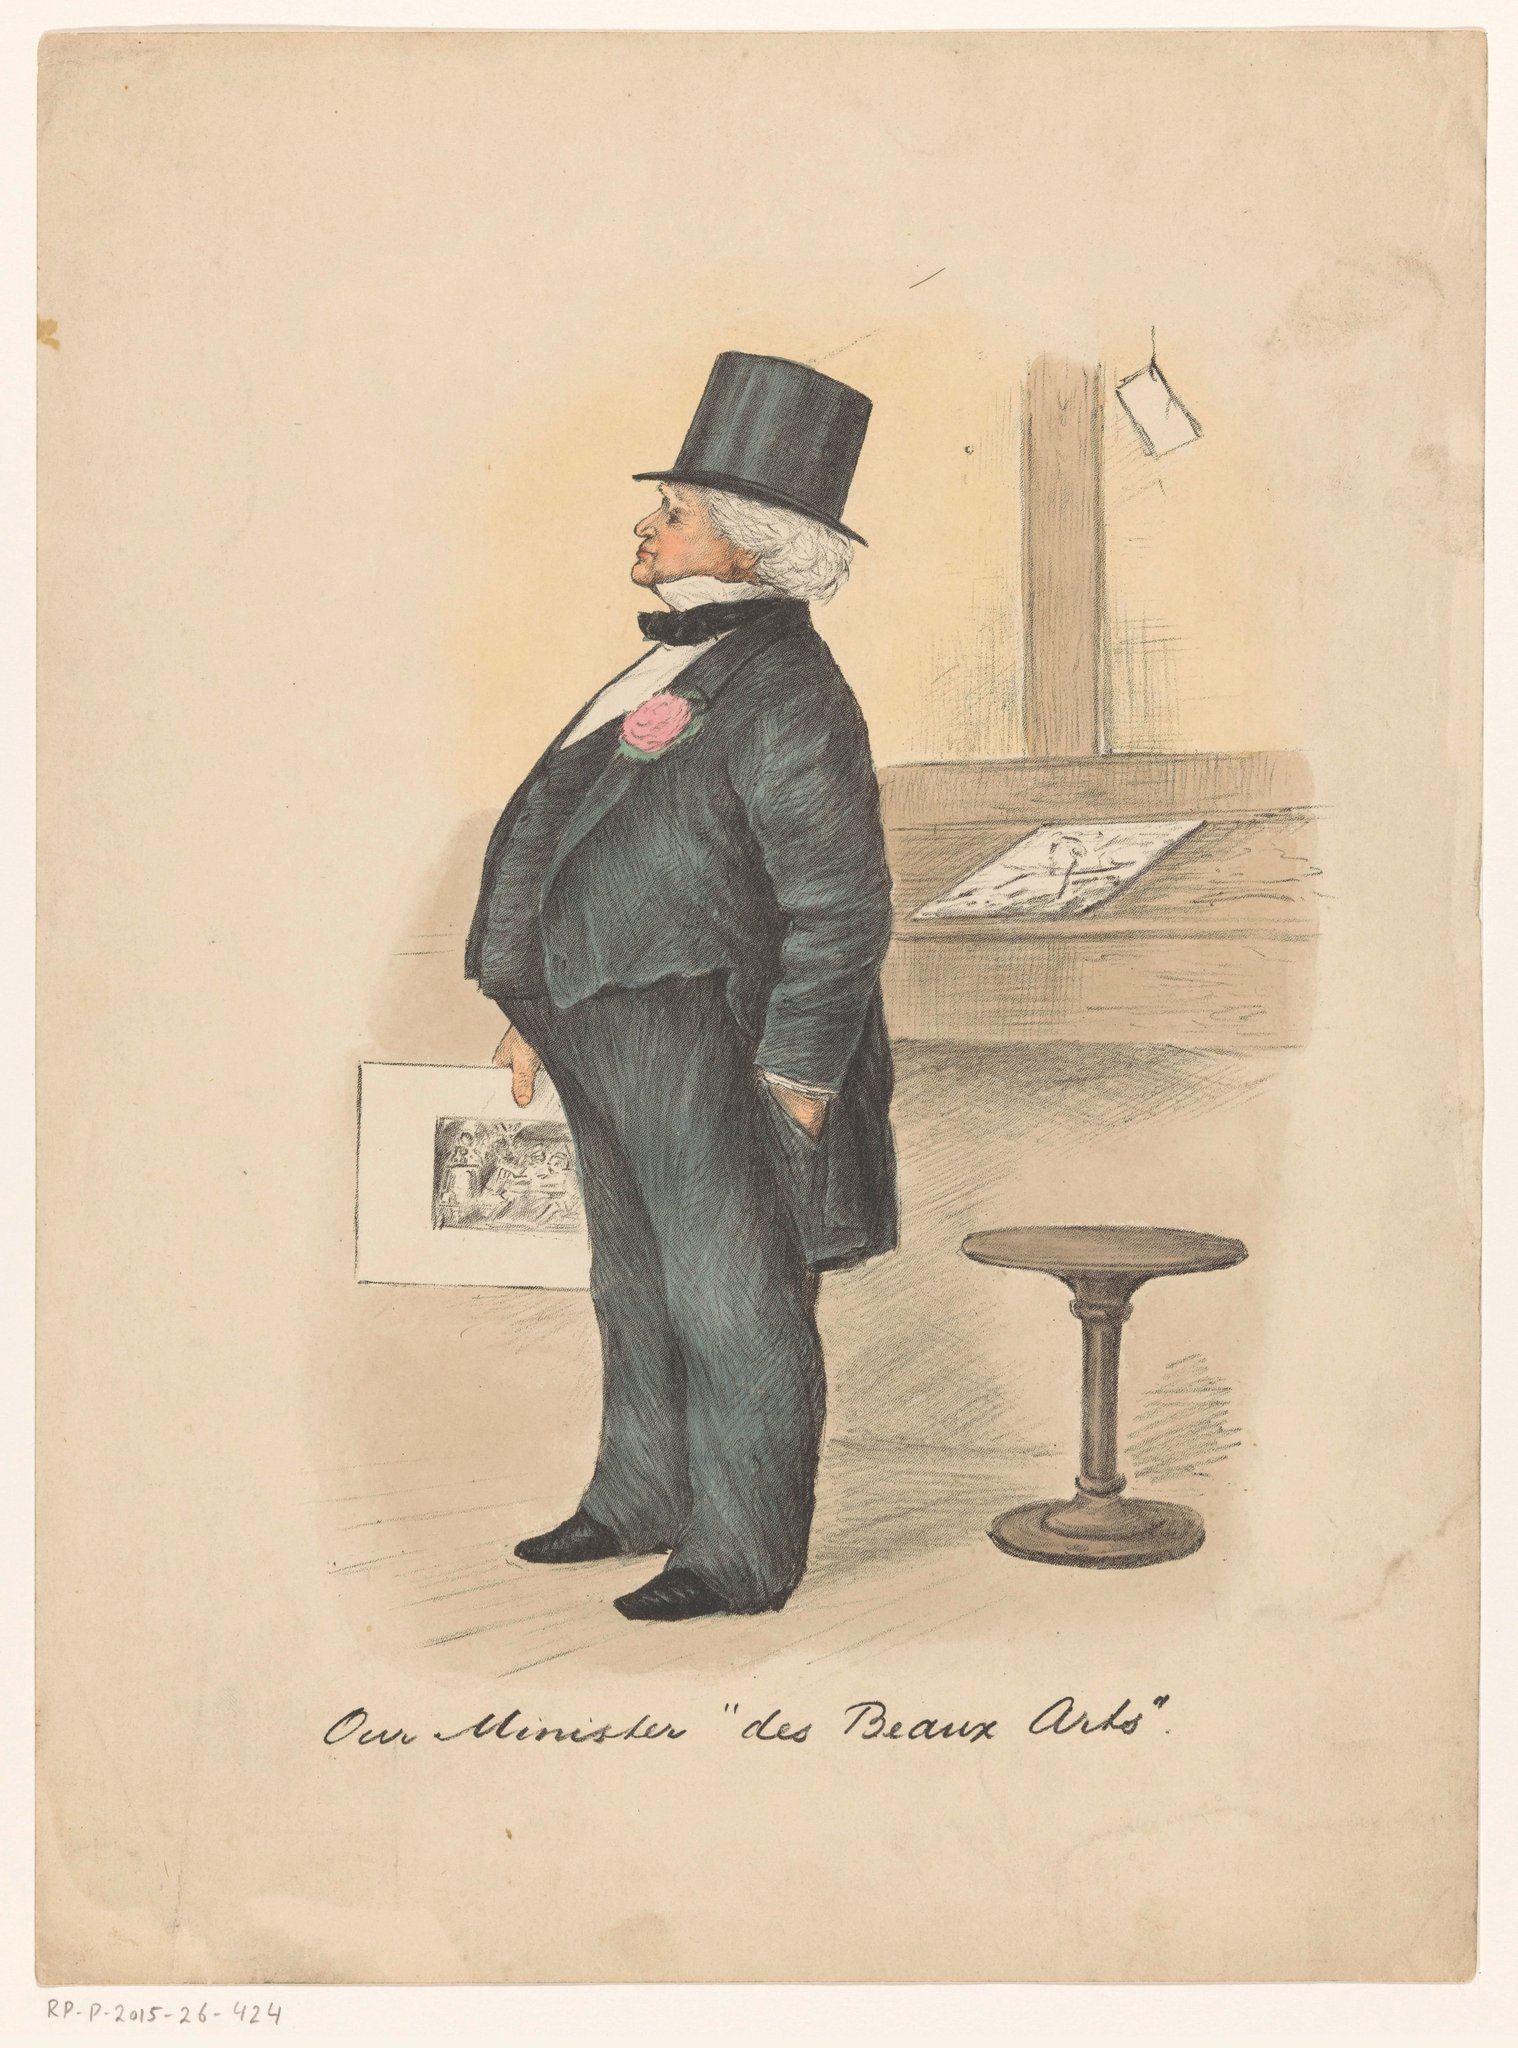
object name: print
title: Man met een prent in zijn hand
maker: Anonymous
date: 1875-1925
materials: paper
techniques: hand coloring, lithograph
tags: print, e.g.: engraving, etching, lithograph, head-gear: top hat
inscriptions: collector's mark: Lugt 2228, annotation: ‘auctions’ Lugt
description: Man in driedelig pak met een hoed en een roze roos op zijn revers, in zijn rechterhand een prent.